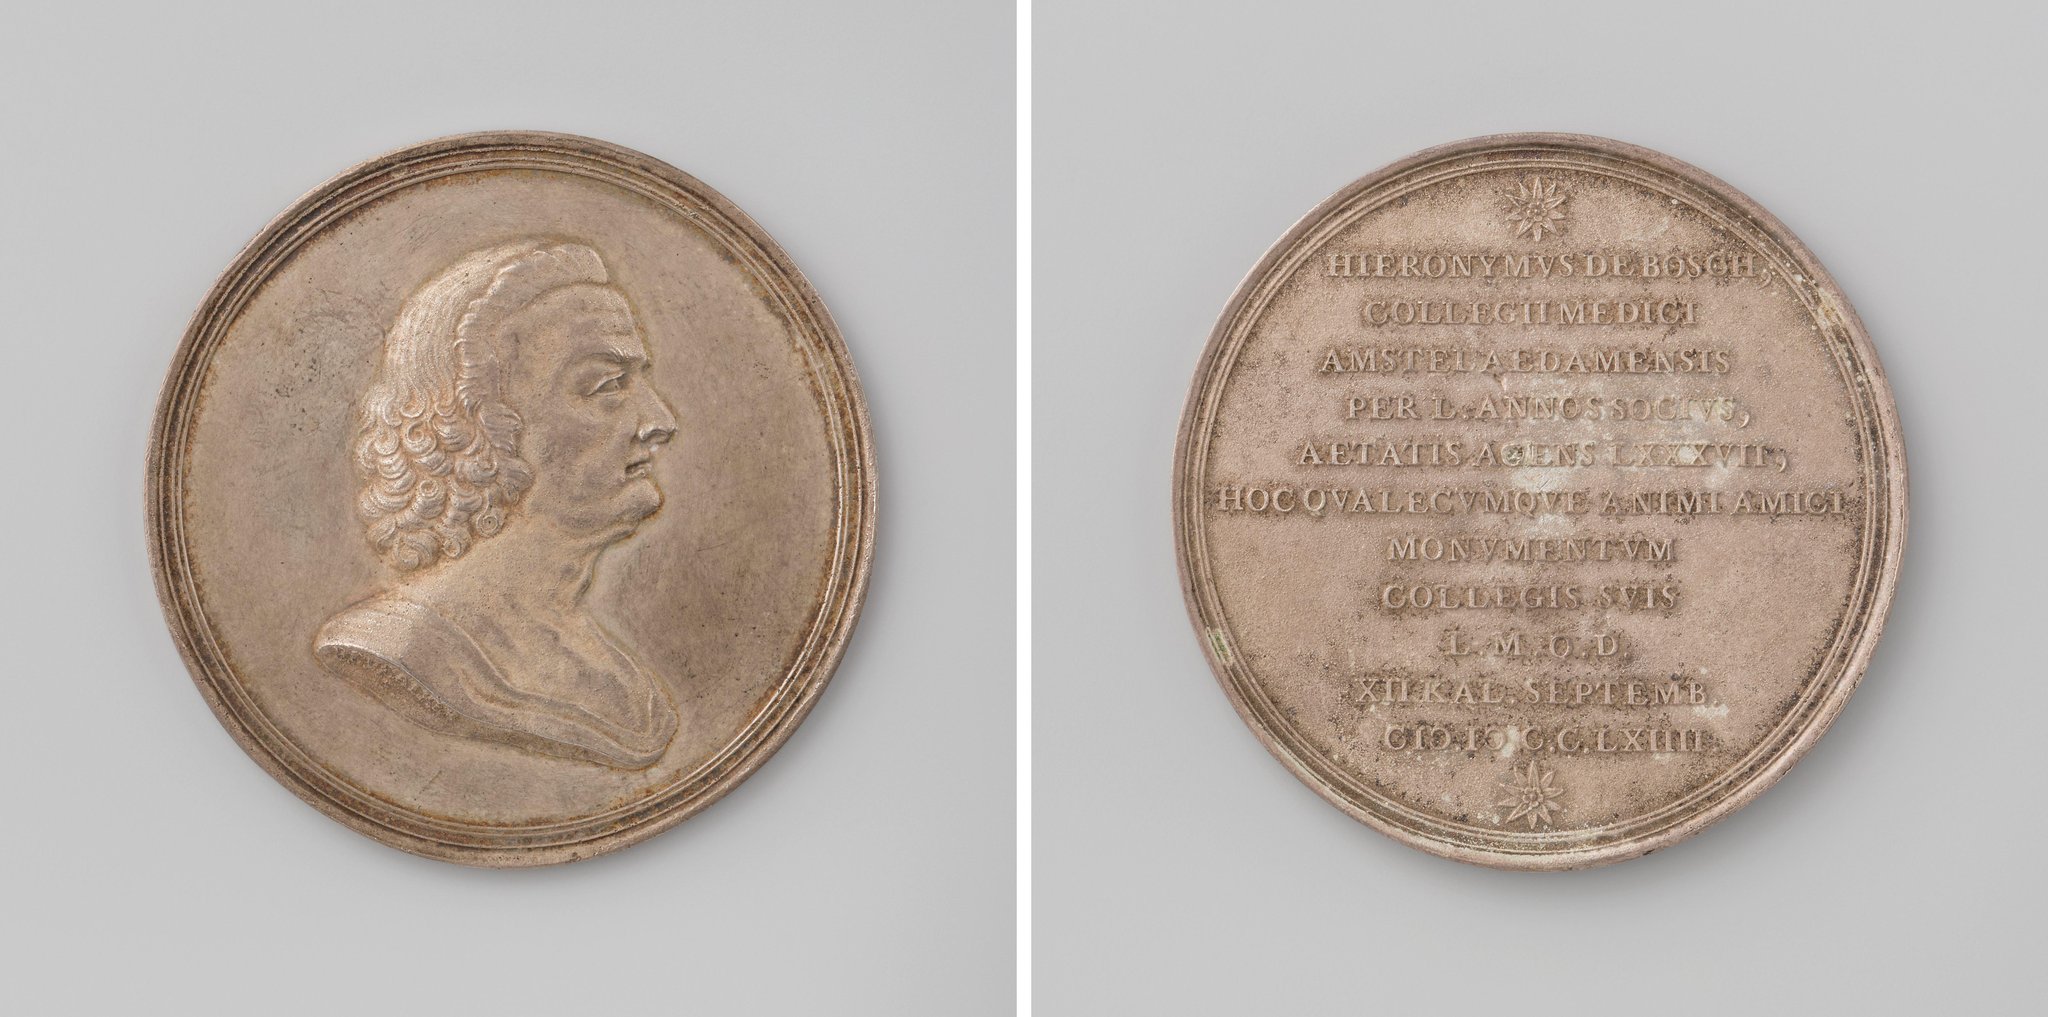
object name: honorary medal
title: Jeronimo de Bosch, vijftig jaar inspecteur van het Collegium Medicum te Amsterdam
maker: barend christiaan van calker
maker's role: medailleur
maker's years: 1739-1813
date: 1764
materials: tin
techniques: casting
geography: zeist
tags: amsterdam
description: Tinnen penning. Voorzijde: borststuk man. Keerzijde: opschrift